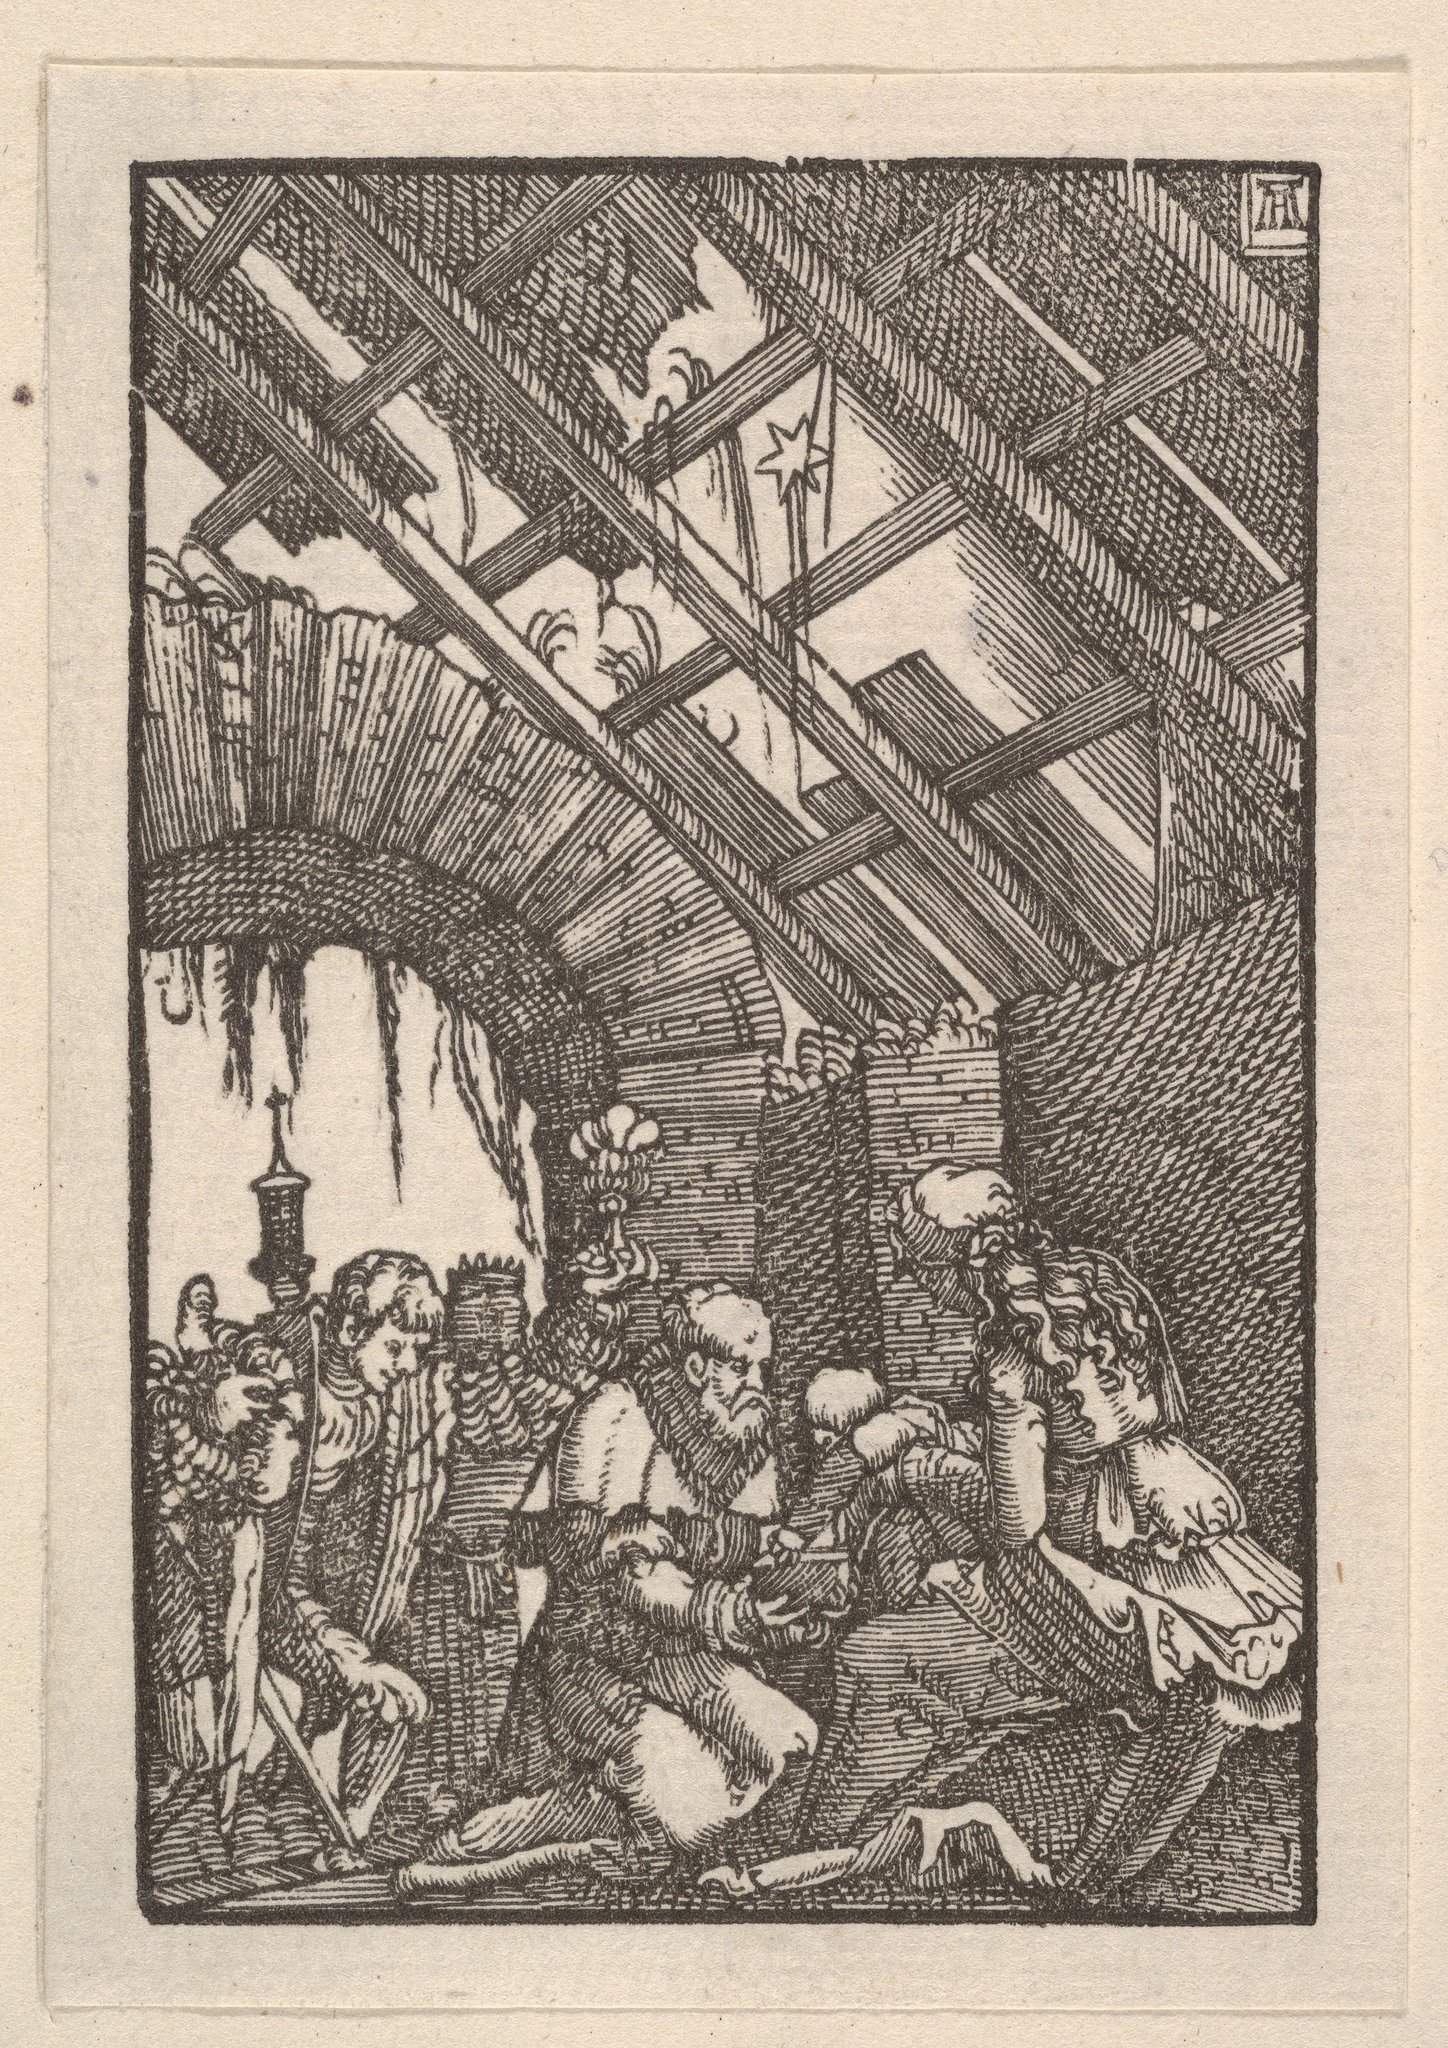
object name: print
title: Adoration of the Magi, from "The Fall and Salvation of Mankind Through the Life and Passion of Christ"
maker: albrecht altdorfer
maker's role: artist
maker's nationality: german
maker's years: 1480-1538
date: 1500-1538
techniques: woodcut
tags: men,jesus,adoration of the magi